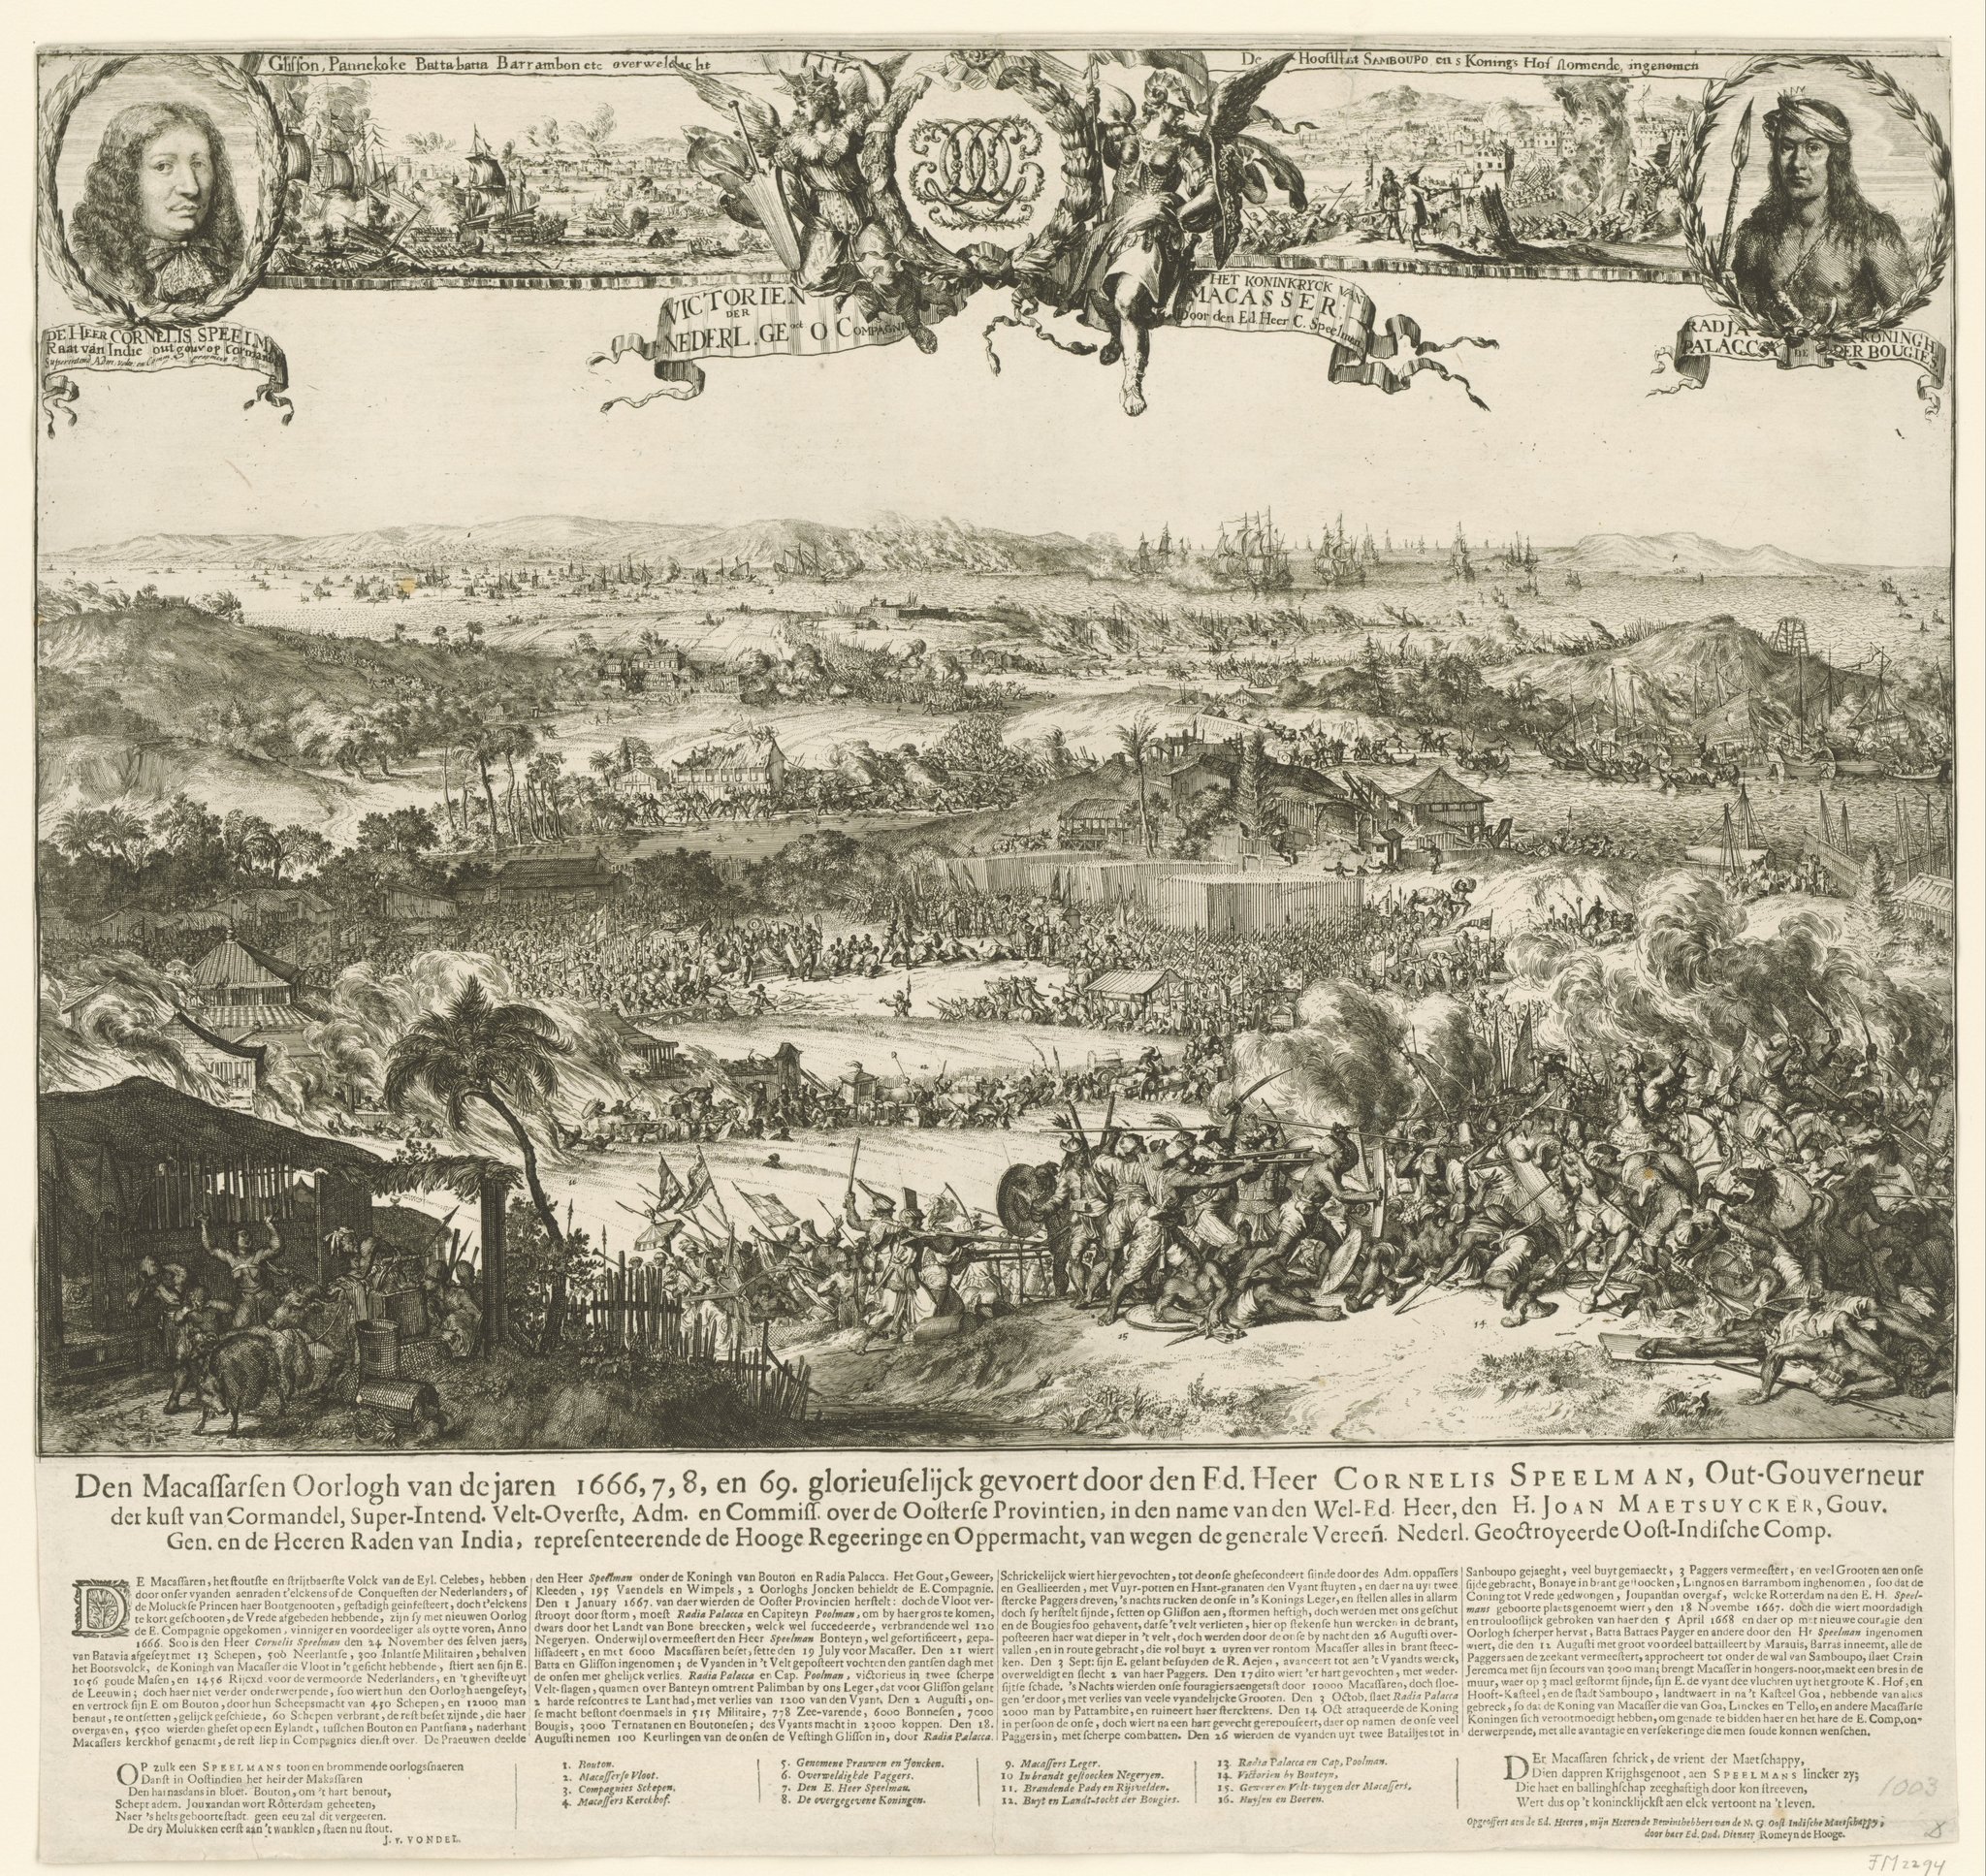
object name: print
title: Overwinningen van Cornelis Speelman op het koninkrijk Makassar, 1666-1669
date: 1670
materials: paper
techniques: etching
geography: northern netherlands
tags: battle, fighting in general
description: Overwinningen van Cornelis Speelman op het koninkrijk Makassar, 1666-1669. Gedetailleerd beeld van het landschap van Makassar met alle gevechten die daar in de jaren 1666, 1667, 1668 en 1669 gevoerd zijn door de oud-gouverneur Cornelis Speelman namens de VOC. Bovenaan de portretten van Speelman en van Radja Palacca, koning der Bougies. Onder de plaat een tekst in 4 kolommen met een chronologische beschrijving van het verloop van de gebeurtenissen, een vers van Vondel van 6 regels, de opdracht van De Hooghe van deze plaat aan de bewindhebbers van de VOC en de legenda 1-16.